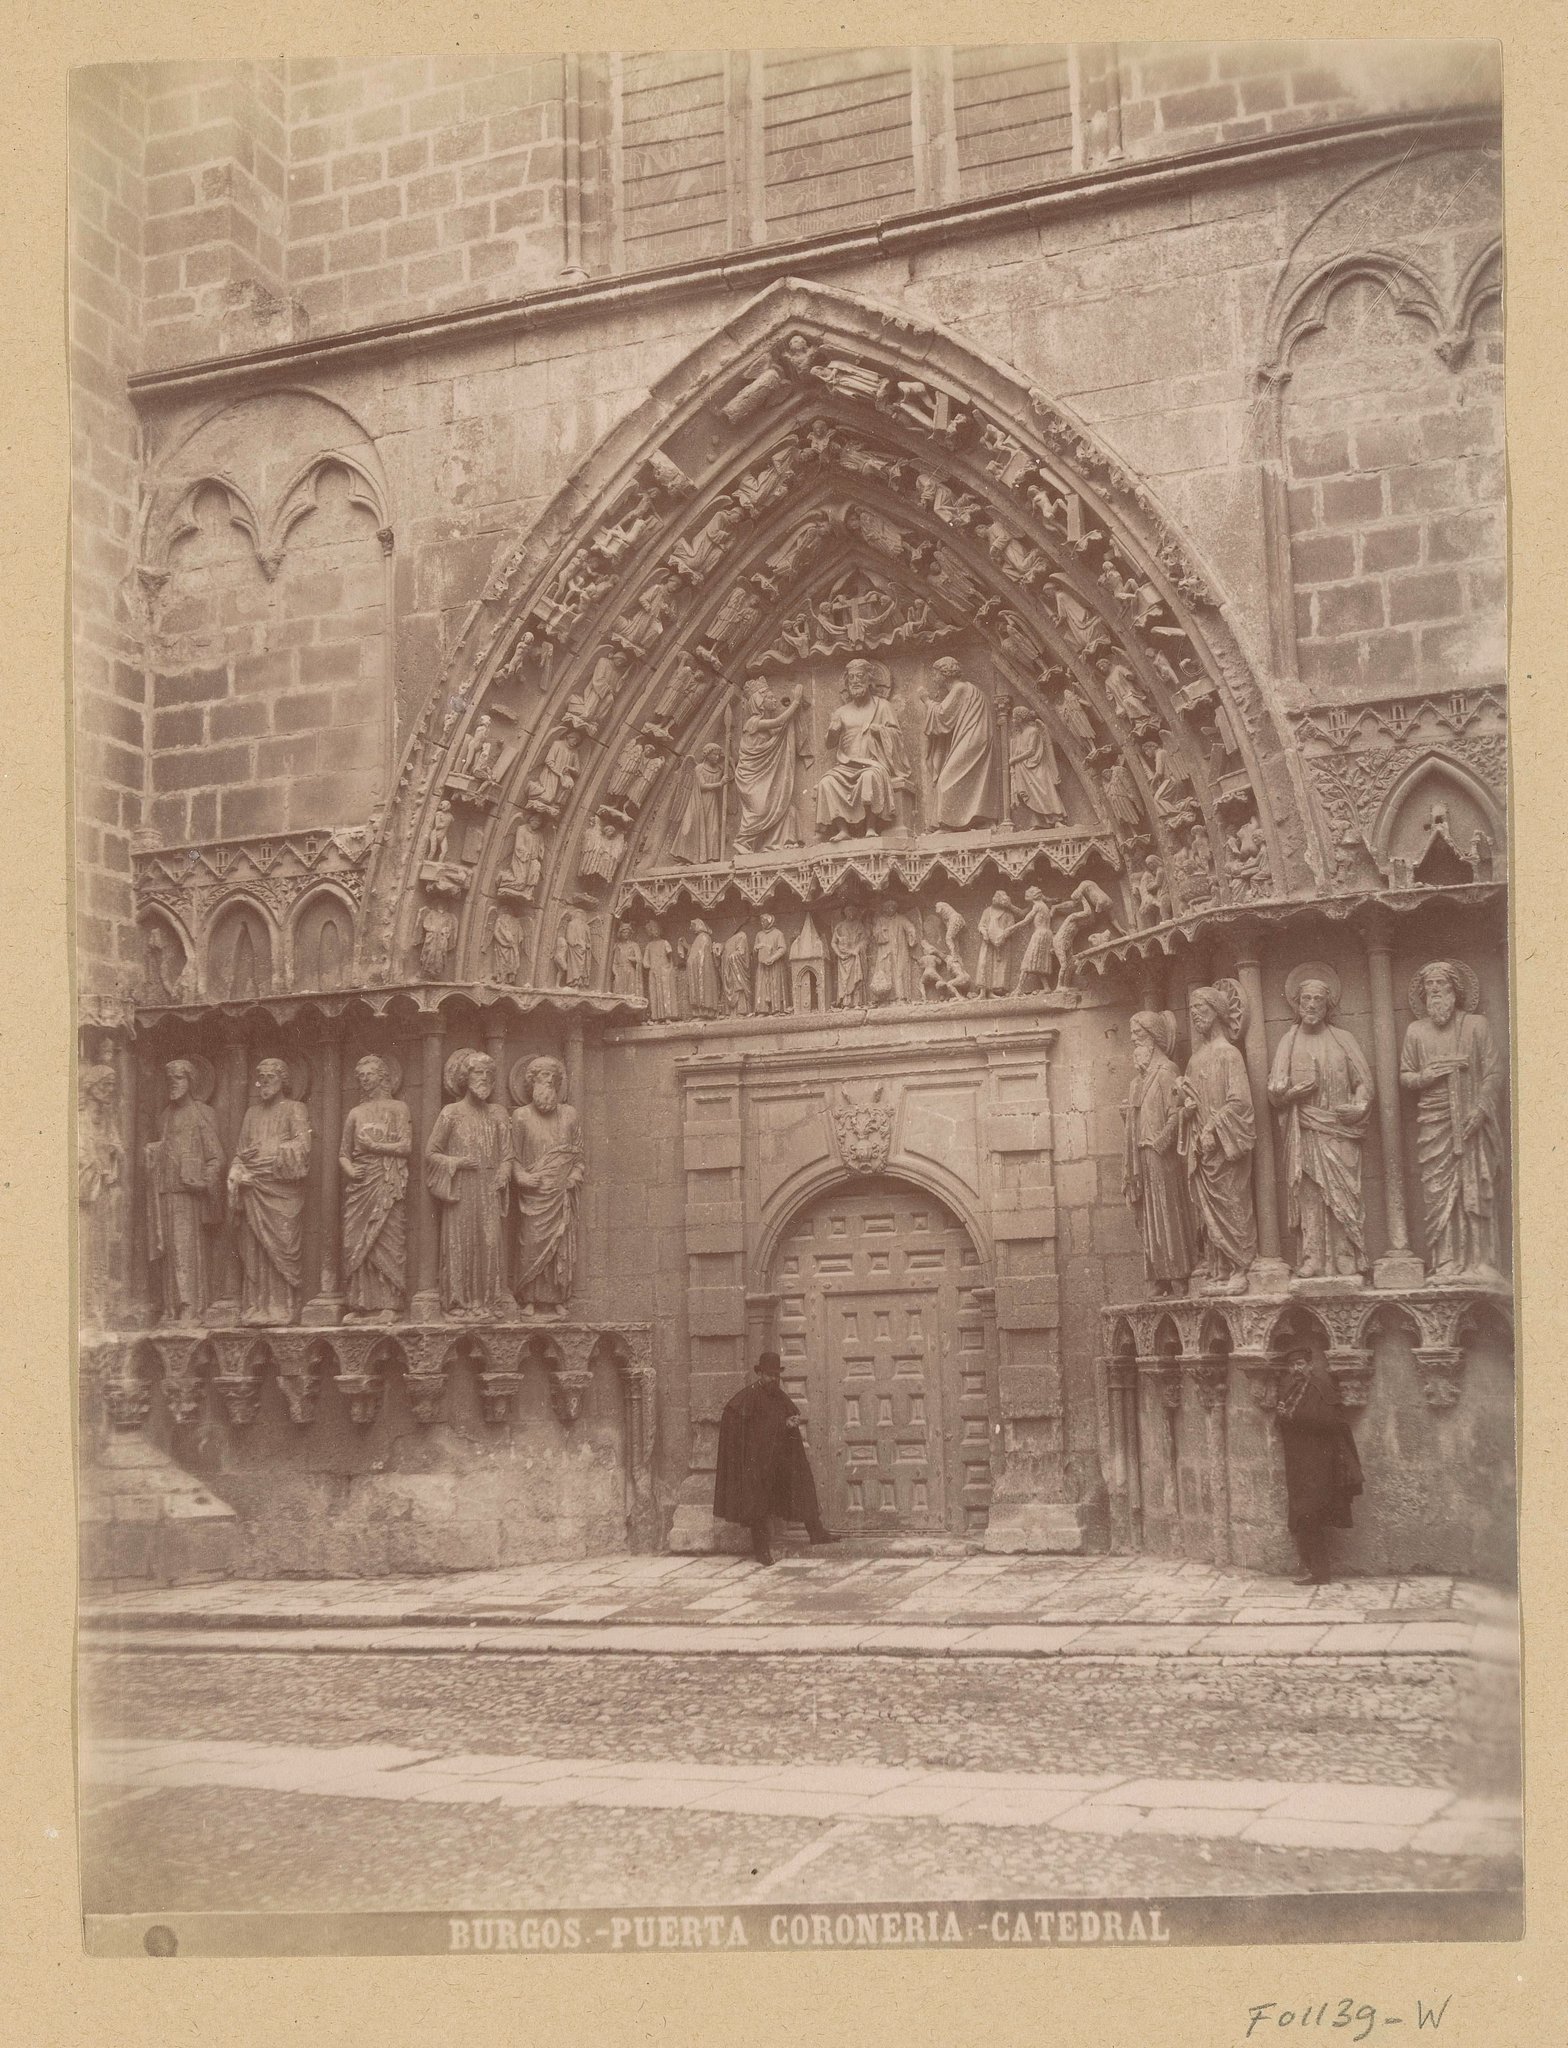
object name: photograph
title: Gezicht op de Coronería poort van de kathedraal van Burgos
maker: Anonymous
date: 1851-1890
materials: paper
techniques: albumen print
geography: burgos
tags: parts of church exterior and annexes: portal